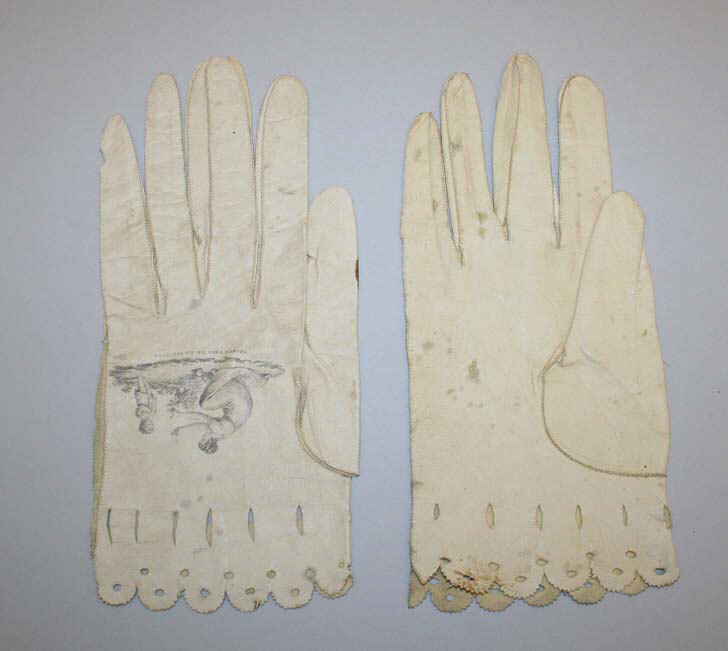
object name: glove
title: Gloves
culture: spanish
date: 1801-1833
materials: leather